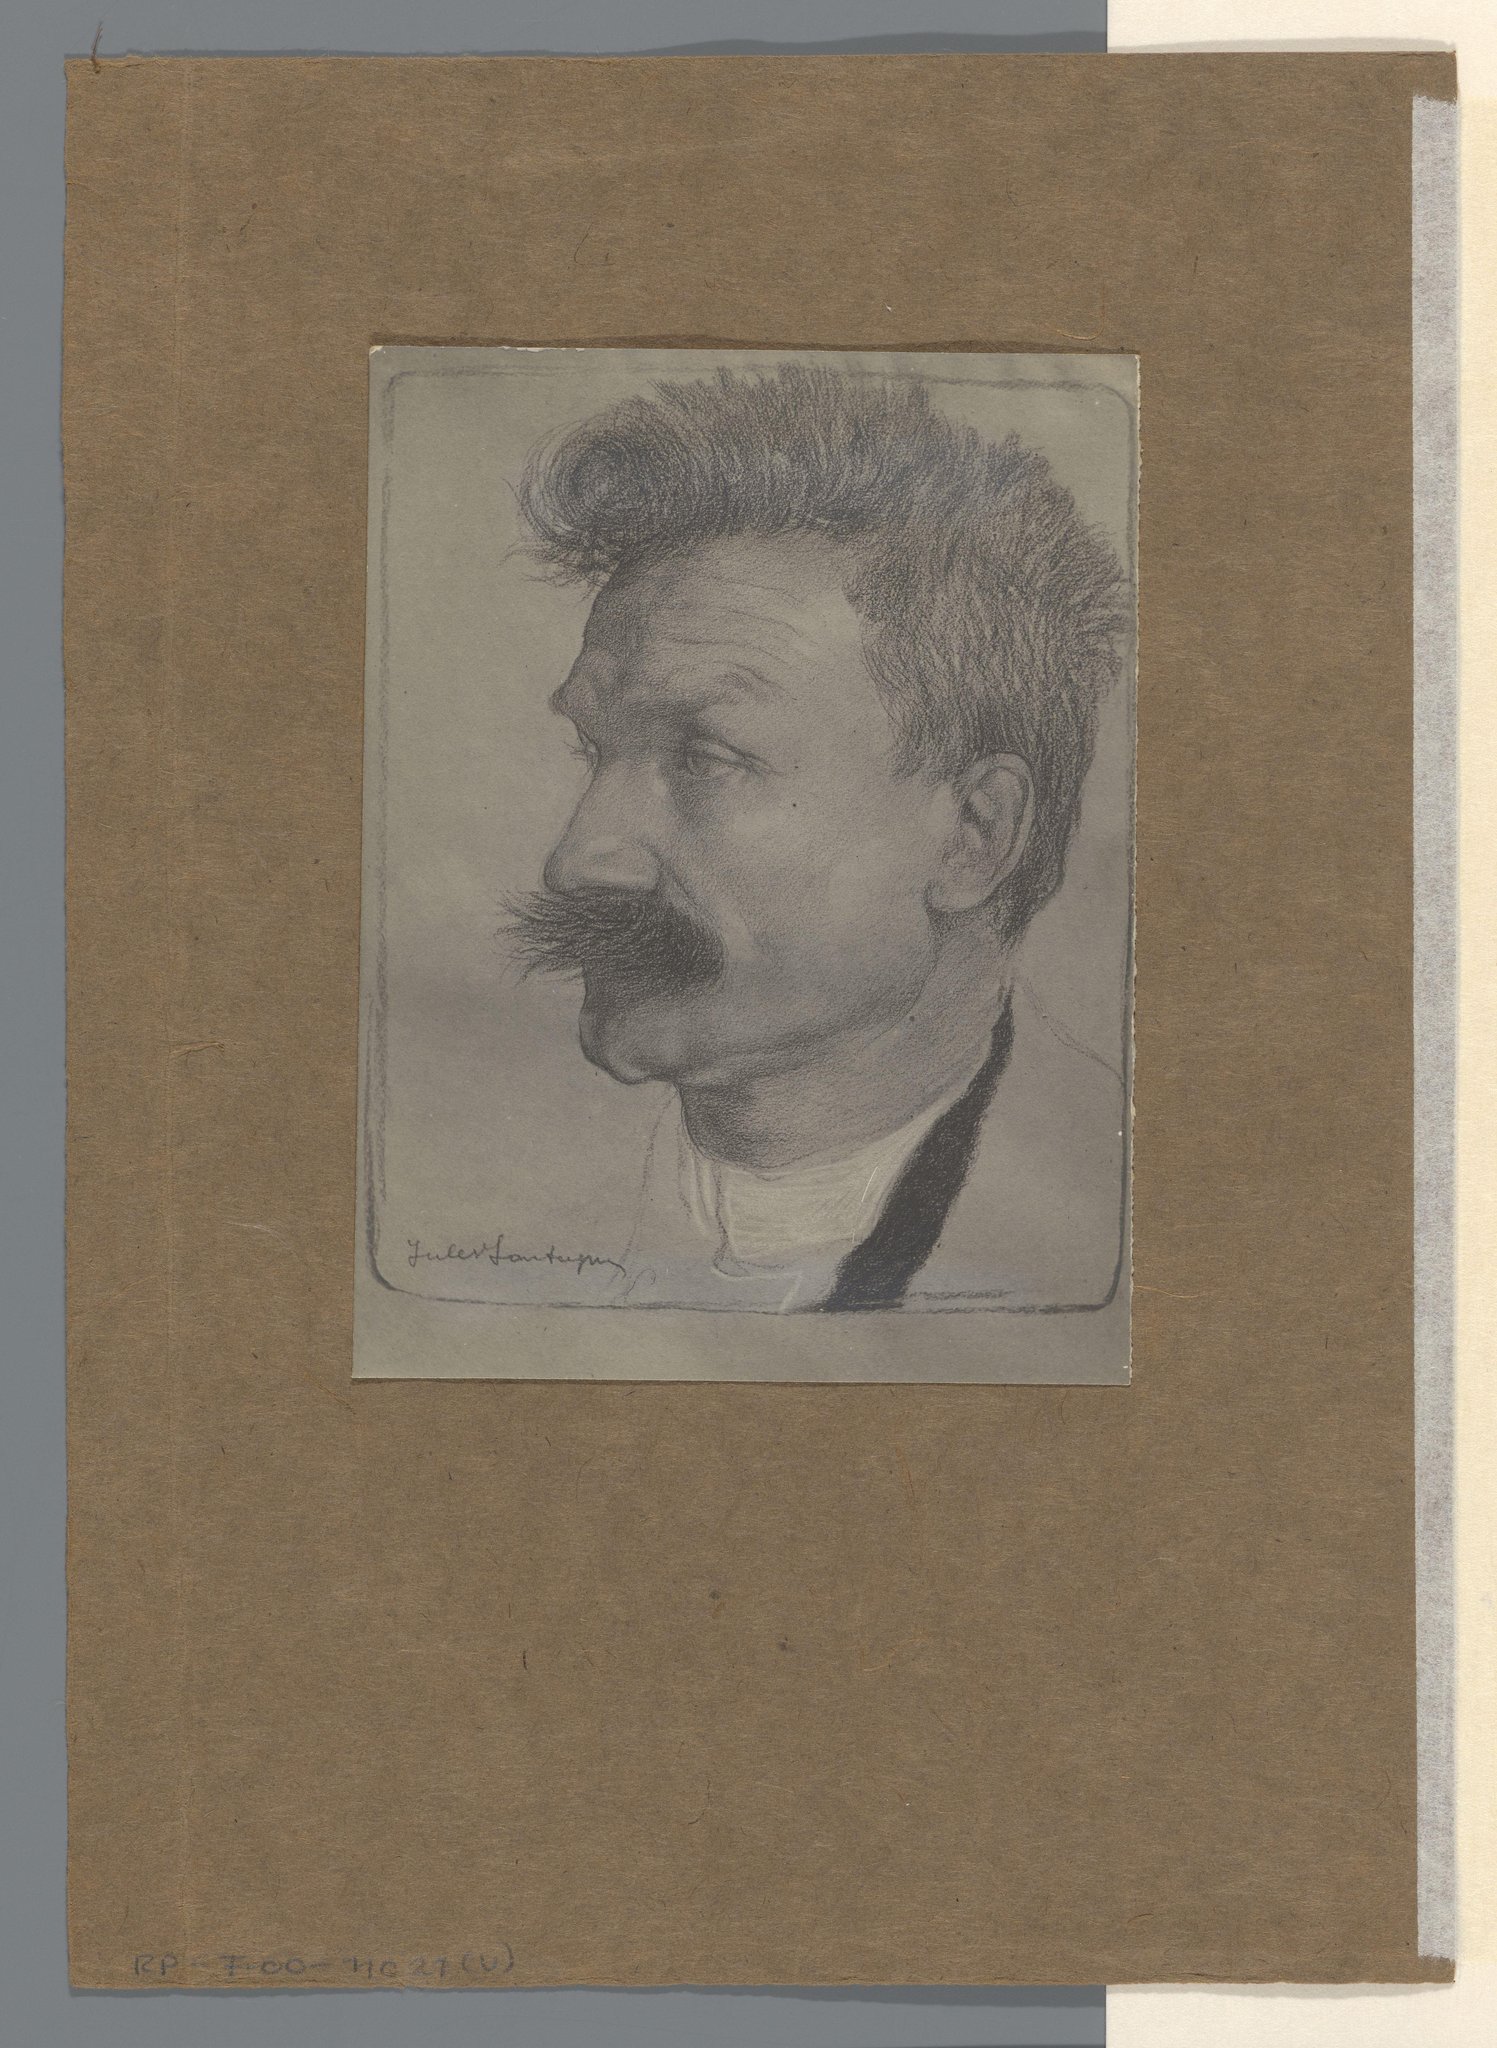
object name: reproduction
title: Fotoreproductie van een tekening, voorstellende een portret van Stijn Streuvels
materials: cardboard, photographic support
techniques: gelatin silver print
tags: stijn streuvels, portrait of a writer